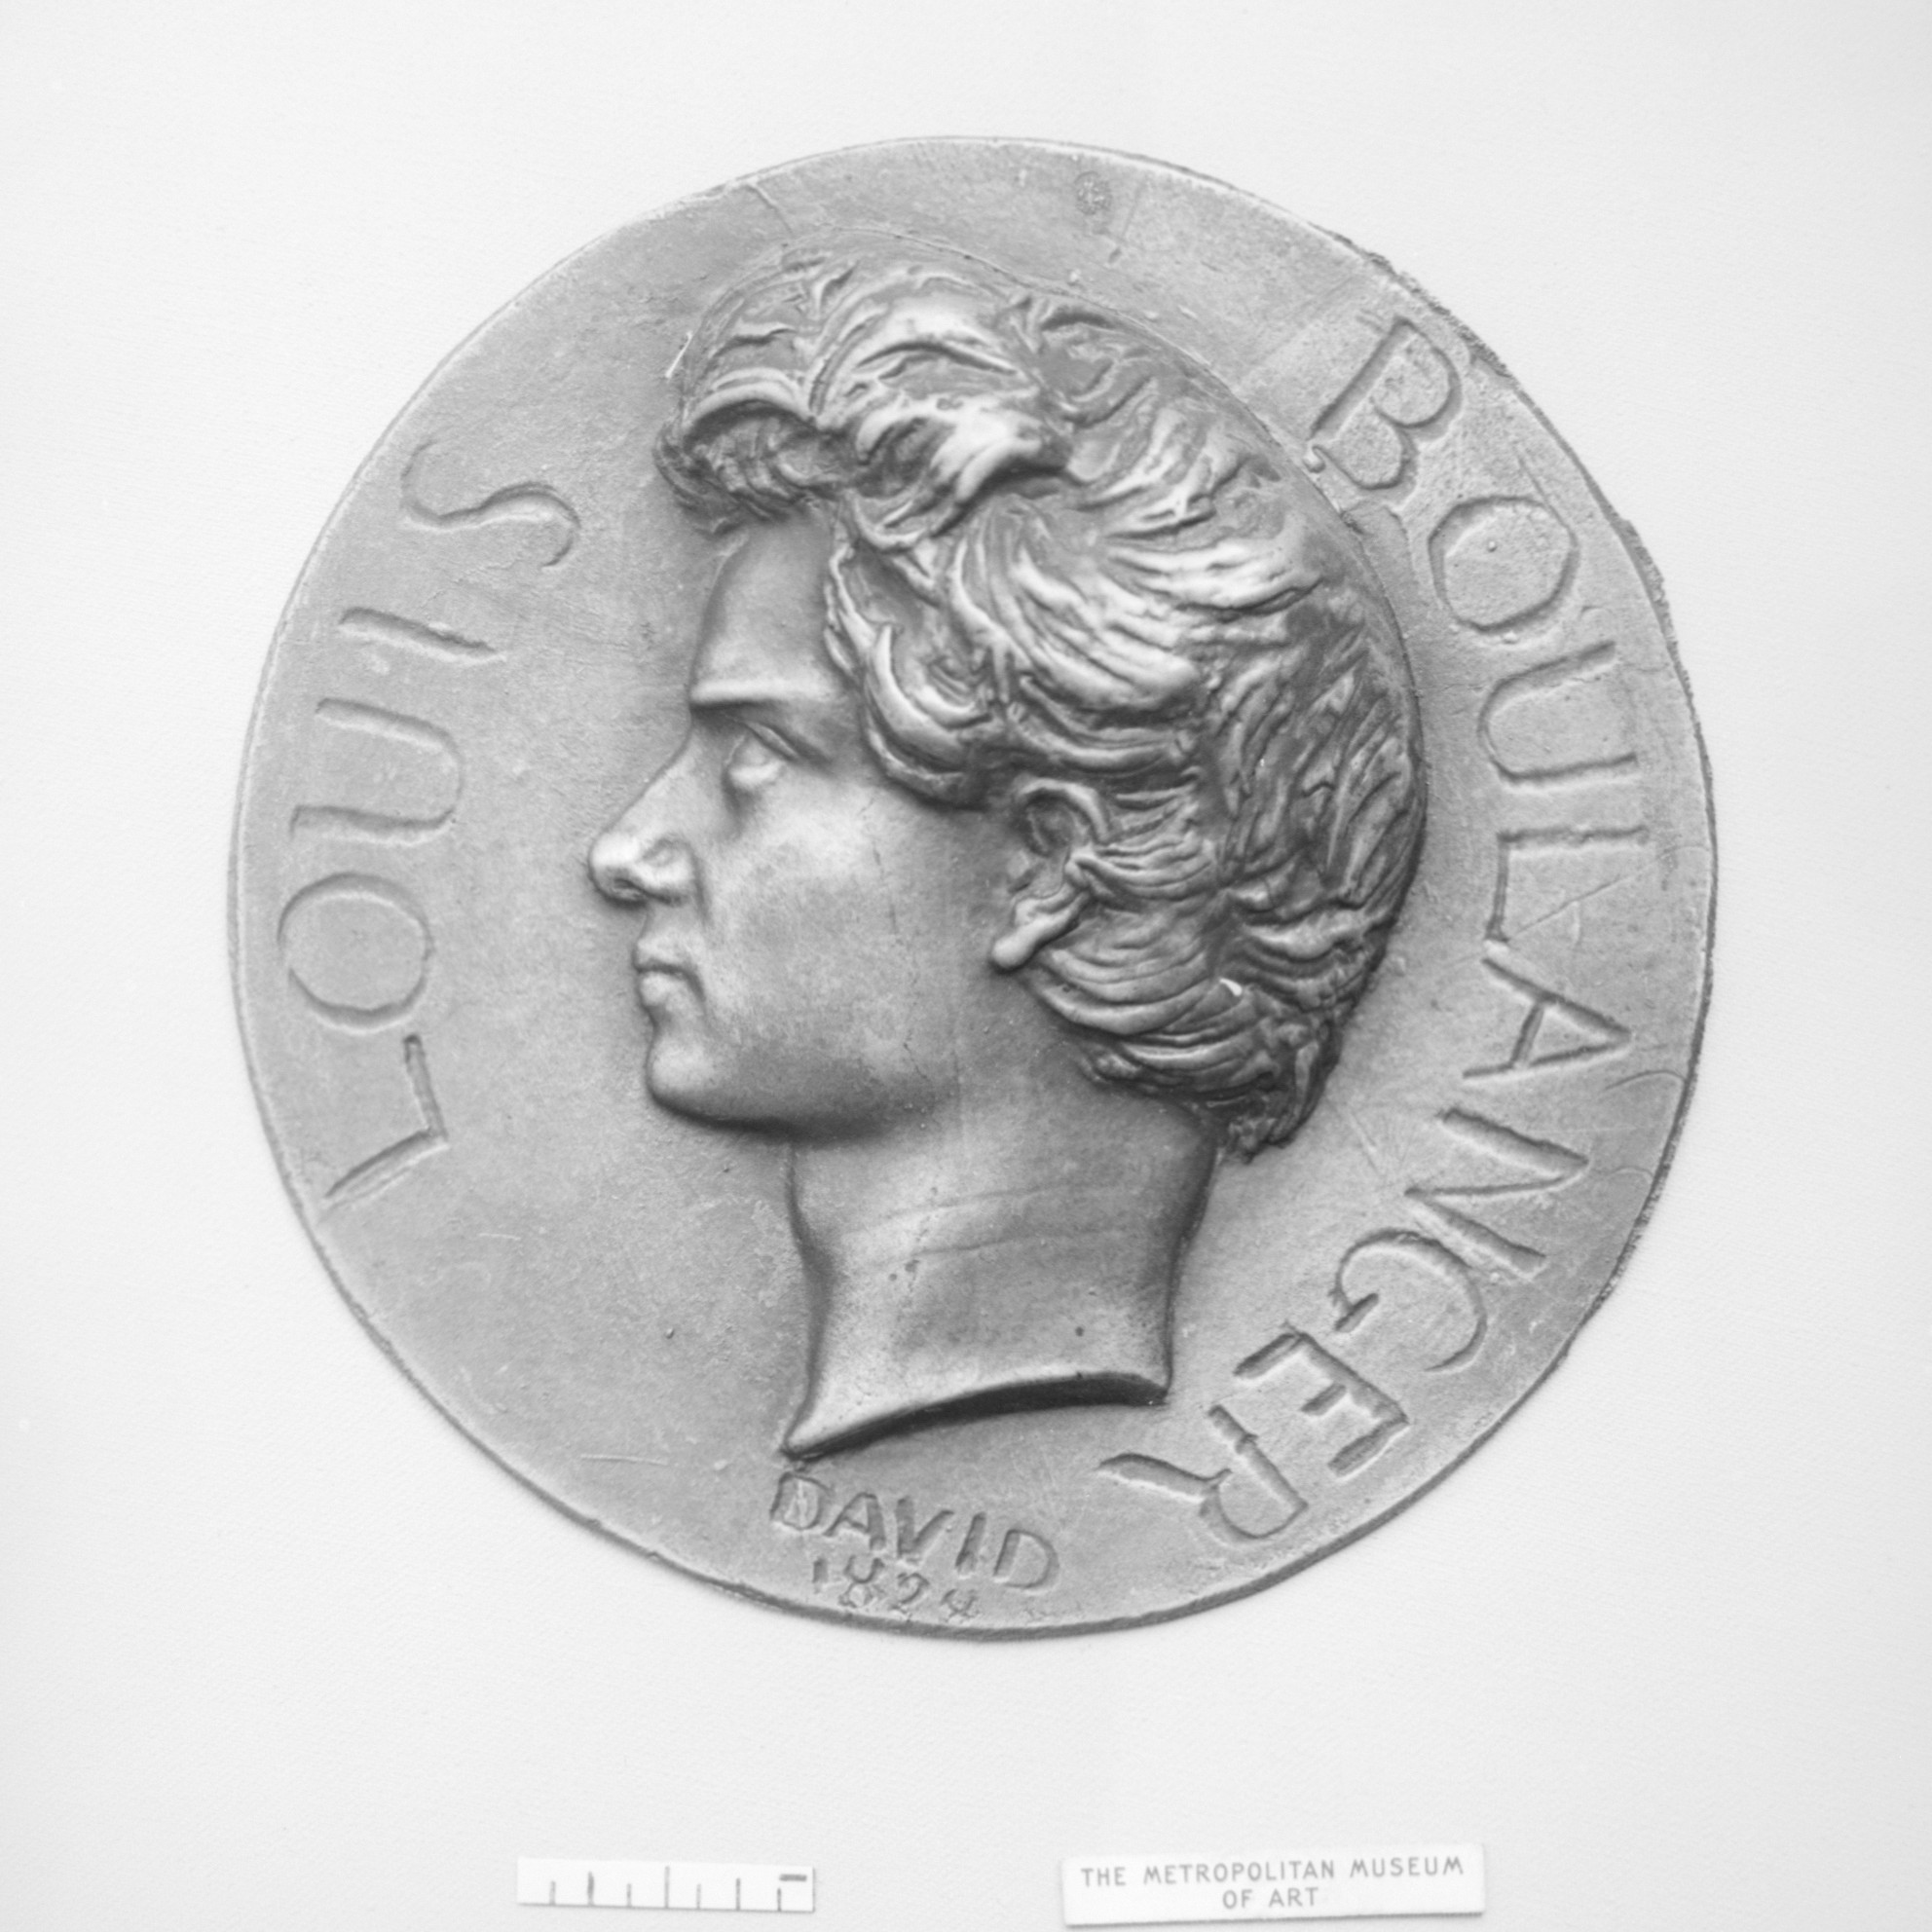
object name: medallion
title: Louis Boulanger (1806–1867), French historical painter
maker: pierre jean david d'angers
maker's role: artist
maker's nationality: french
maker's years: 1788-1856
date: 1828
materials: bronze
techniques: casting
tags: men,profiles